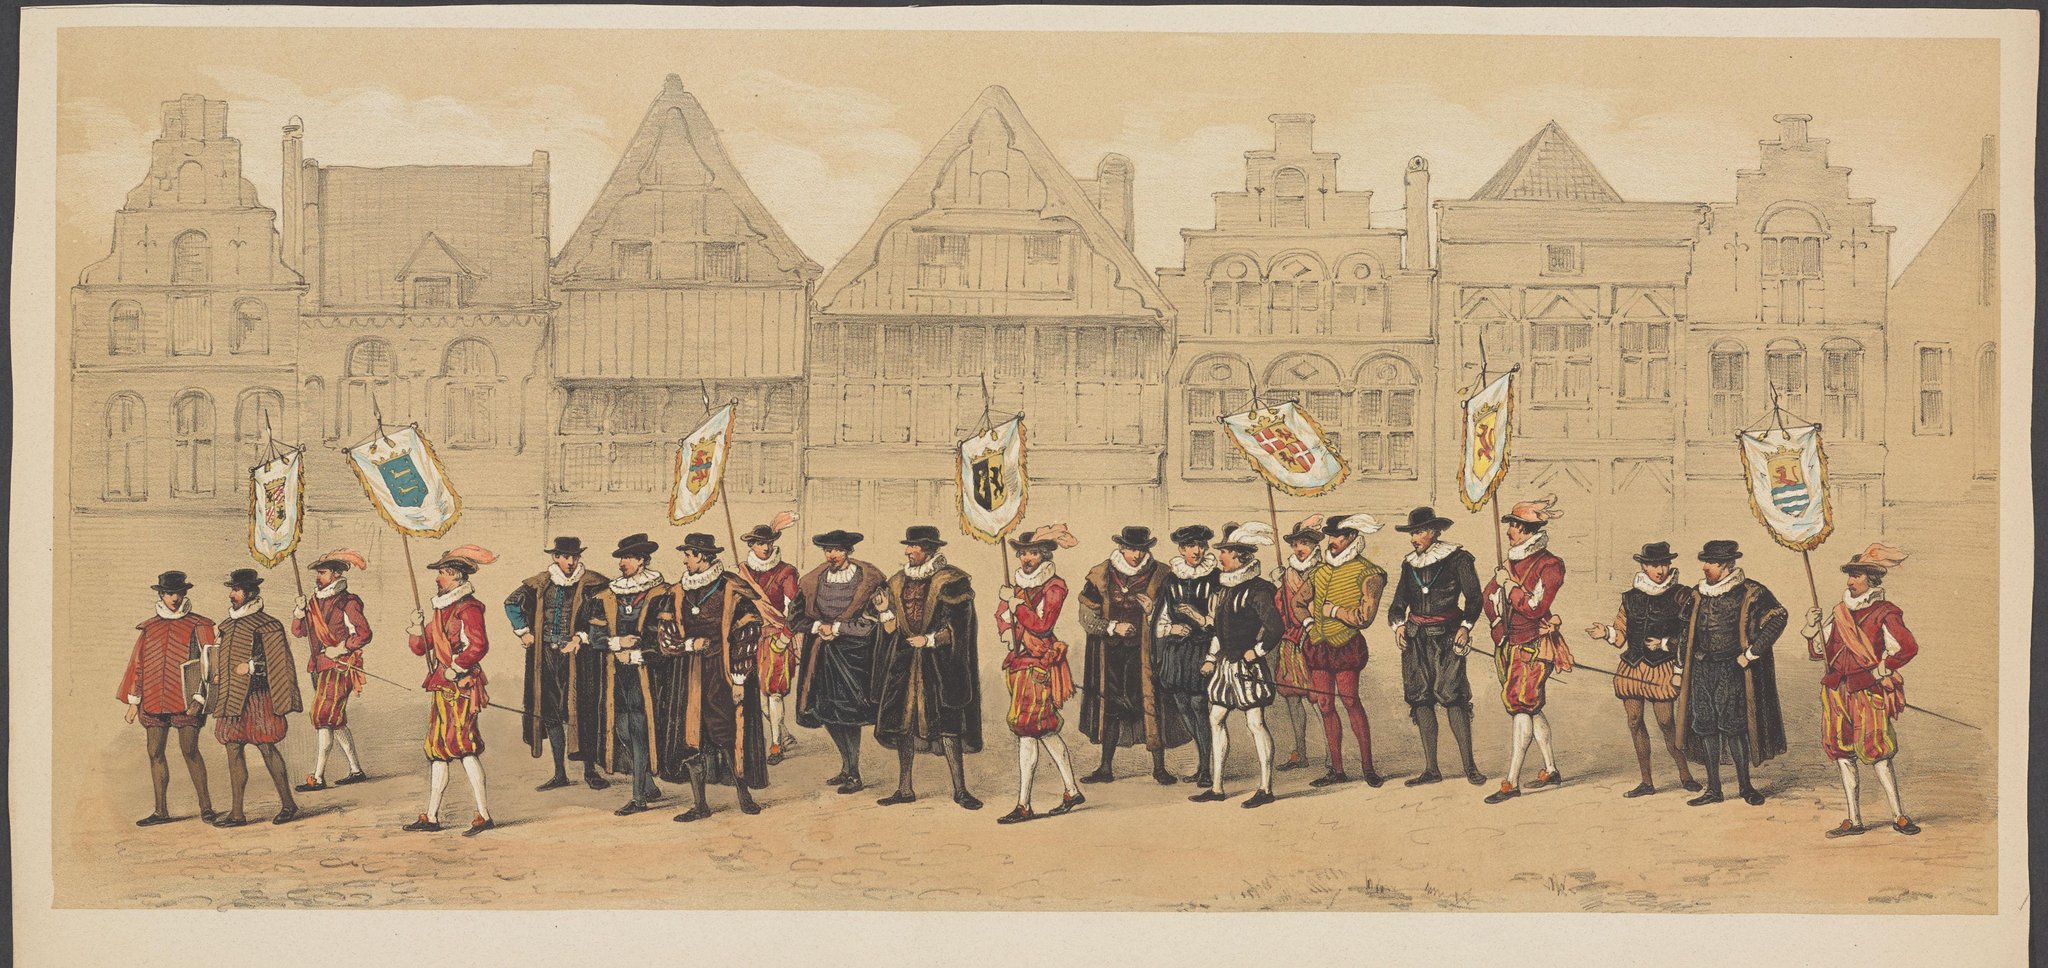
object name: print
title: De staatslieden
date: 1856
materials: paper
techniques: hand coloring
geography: utrecht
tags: delft, william i (prince of orange), students' pageant, costumes used in pageants, utrecht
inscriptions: collector's mark: Lugt 2228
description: Een groep van staatslieden van de zeven verschillende provincies, te voet. Onderdeel van een groep van vijf platen met verklaring van de historische optocht in maskerade opgevoerd door de studenten van de Utrechtse Hogeschool op 17 juni 1856 ter gelegenheid van de viering van haar 220-jarige bestaan.